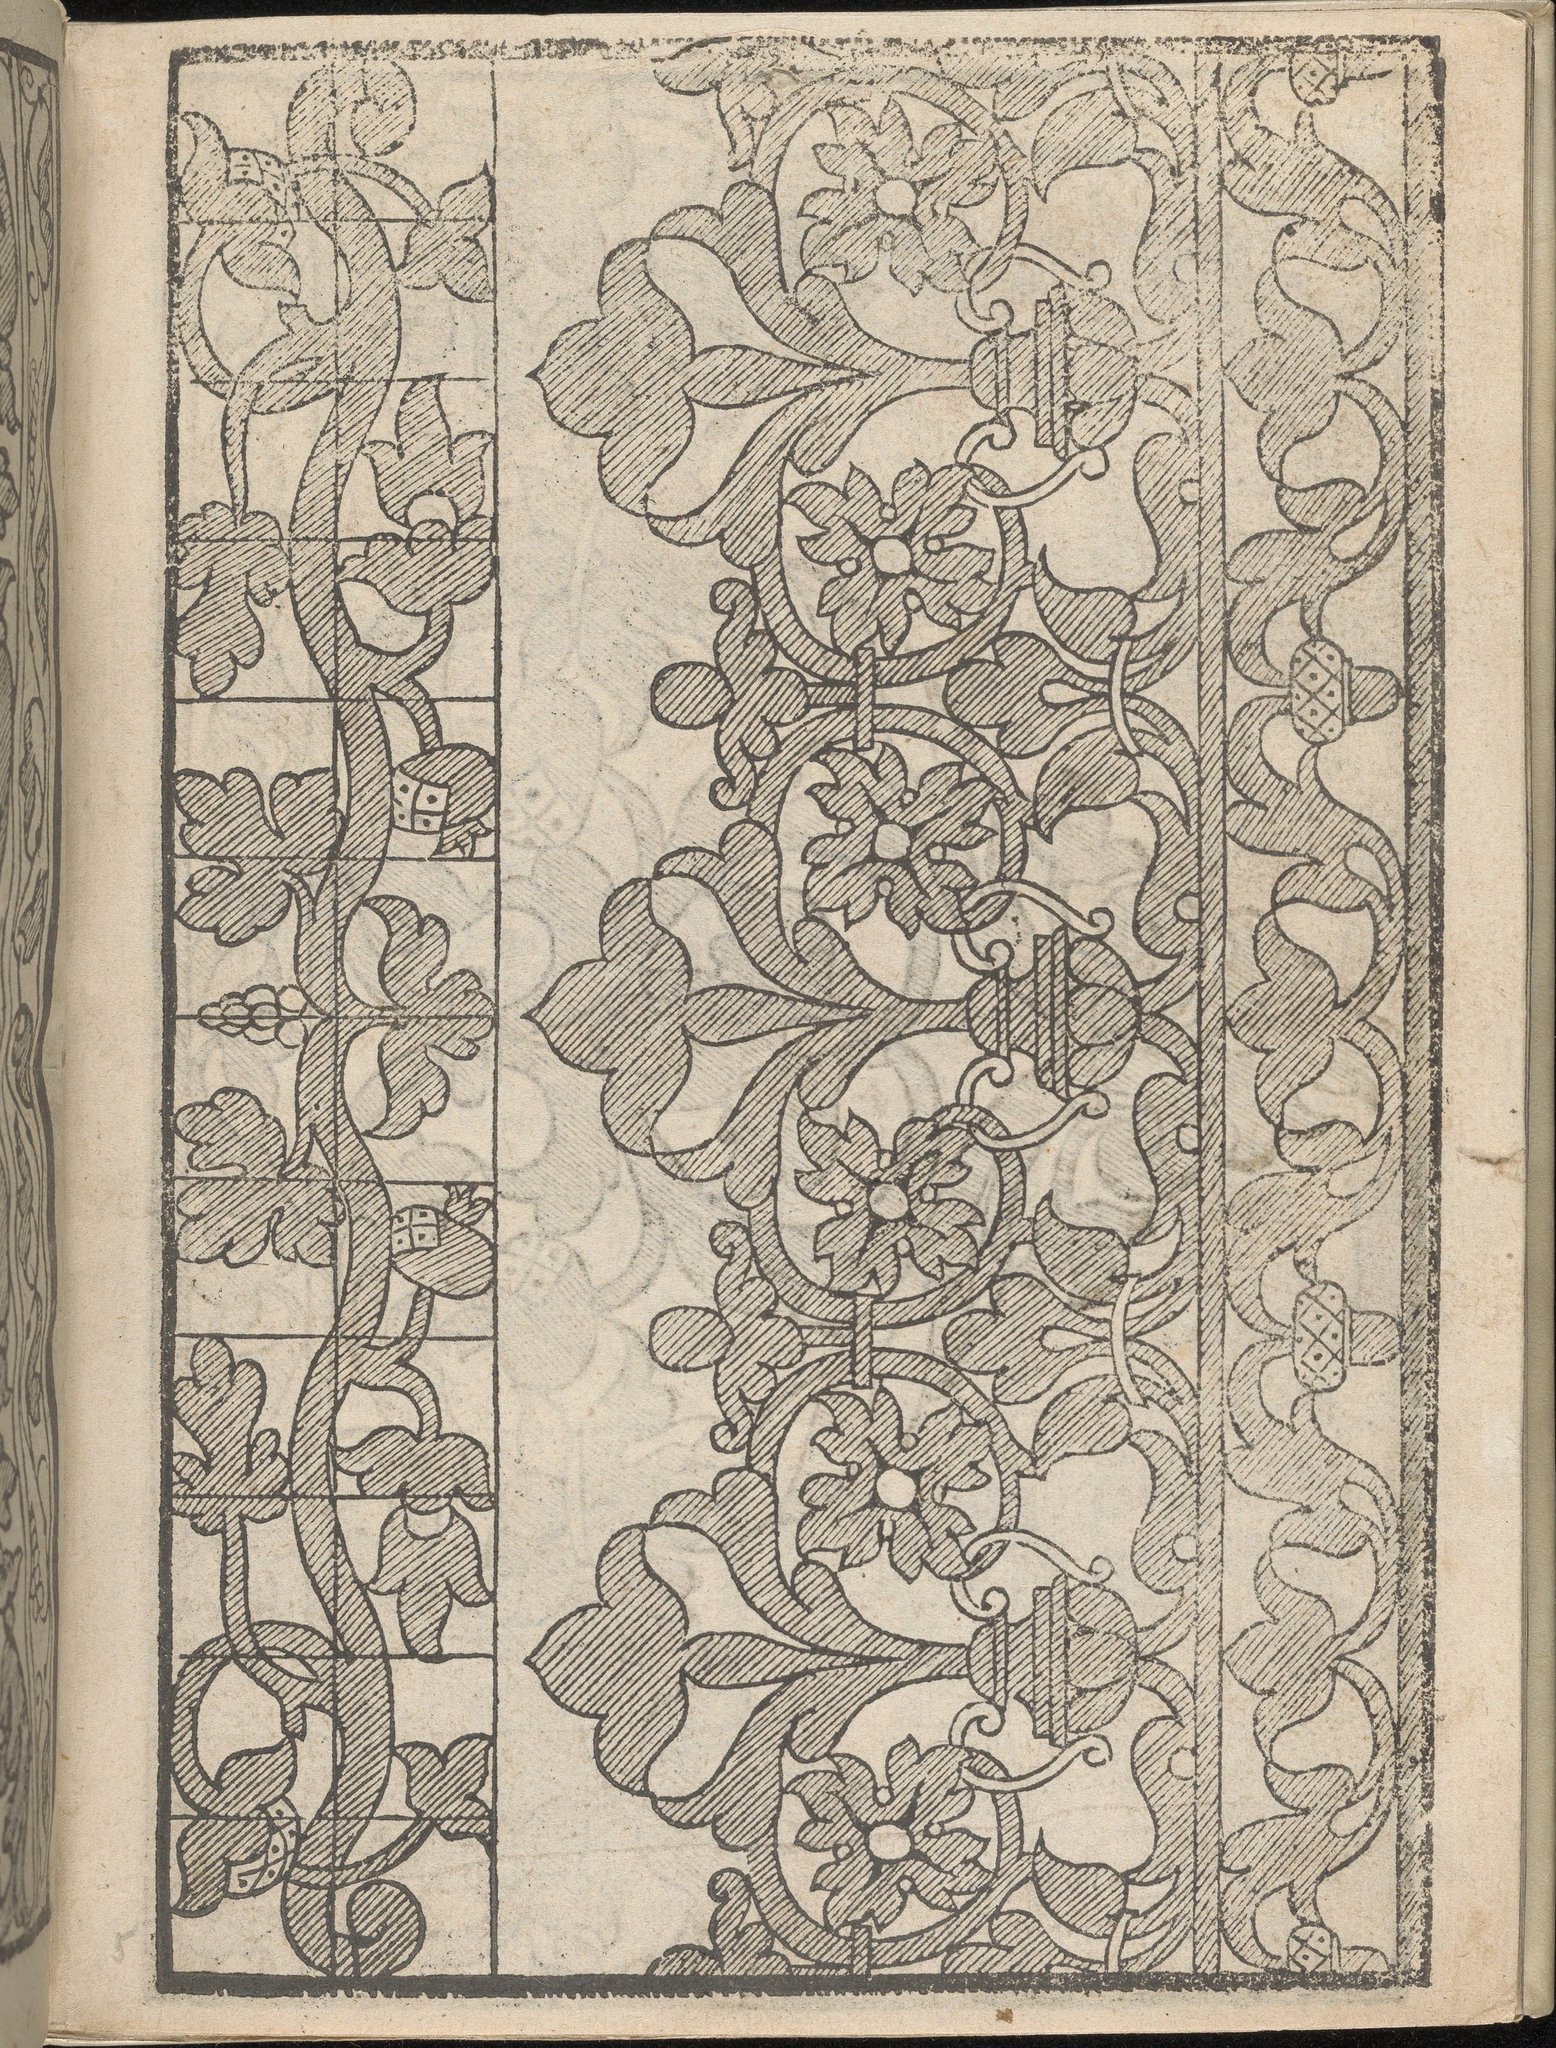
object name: book print ornament architecture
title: Lucidario di Recami, page 6 (recto)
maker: iseppo foresto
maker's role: designer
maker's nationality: italian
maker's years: 1520-1580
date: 1564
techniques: woodcut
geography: italy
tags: flowers